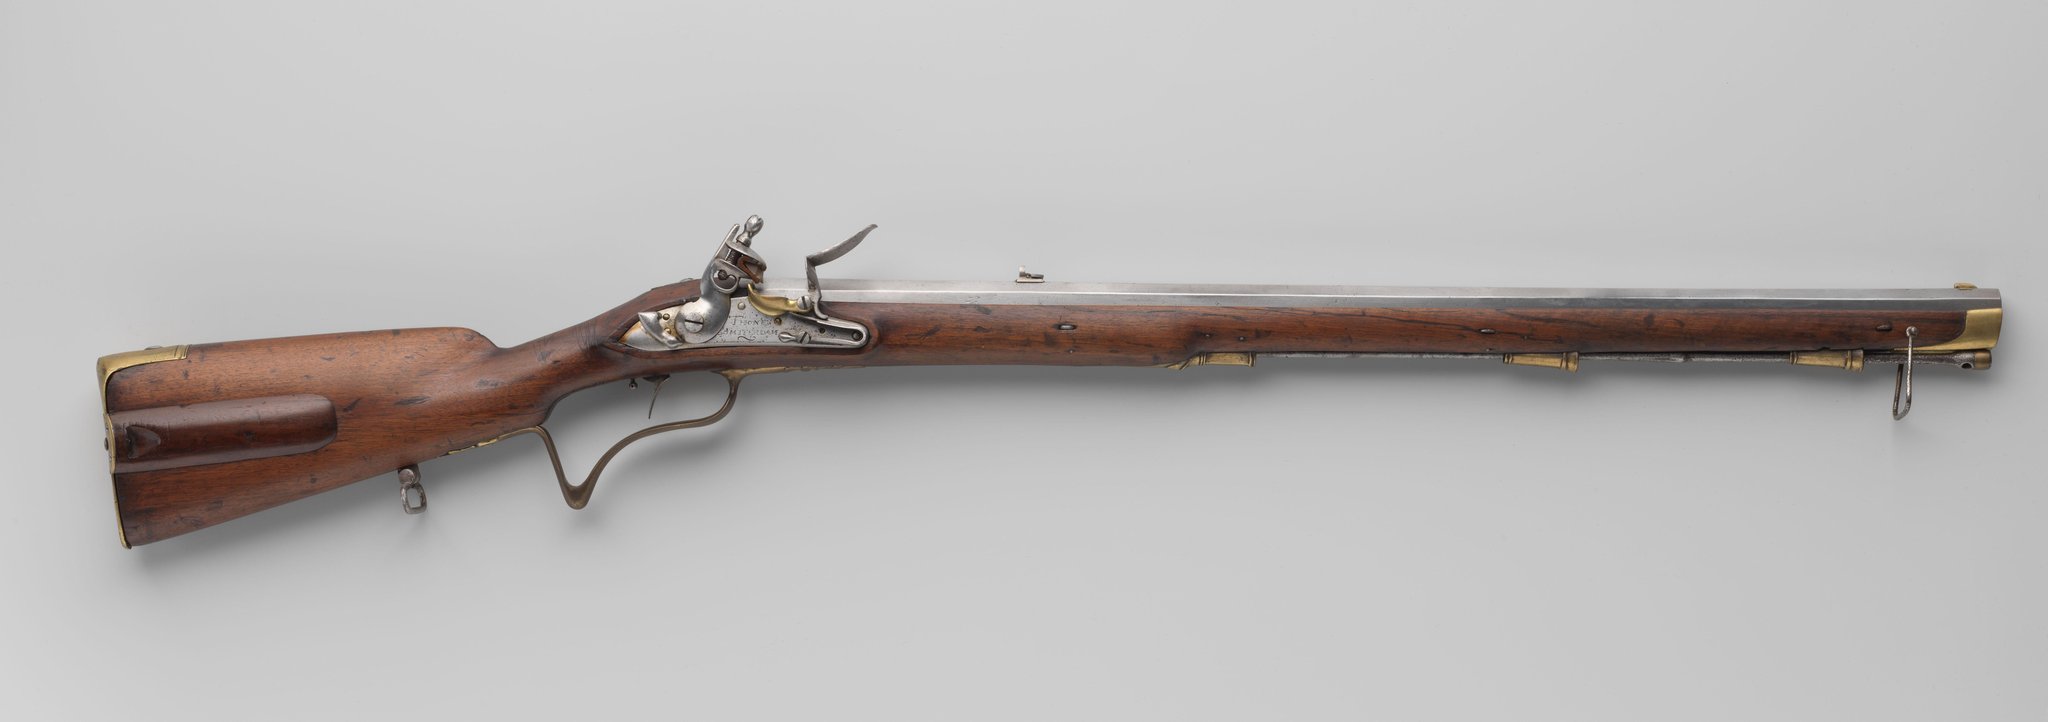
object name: flintlock pistol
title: Vuursteenjagerbus, Staatse leger M. 1798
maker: lambertus michaelis thone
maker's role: weapon manufacturer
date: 1800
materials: brass, iron, steel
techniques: printing, cutting, engraving, pierced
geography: amsterdam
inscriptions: inscription: ‘THONE // AMSTERDAM’, mark: ‘ND (St. 4118)’, mark: ‘G...DF’